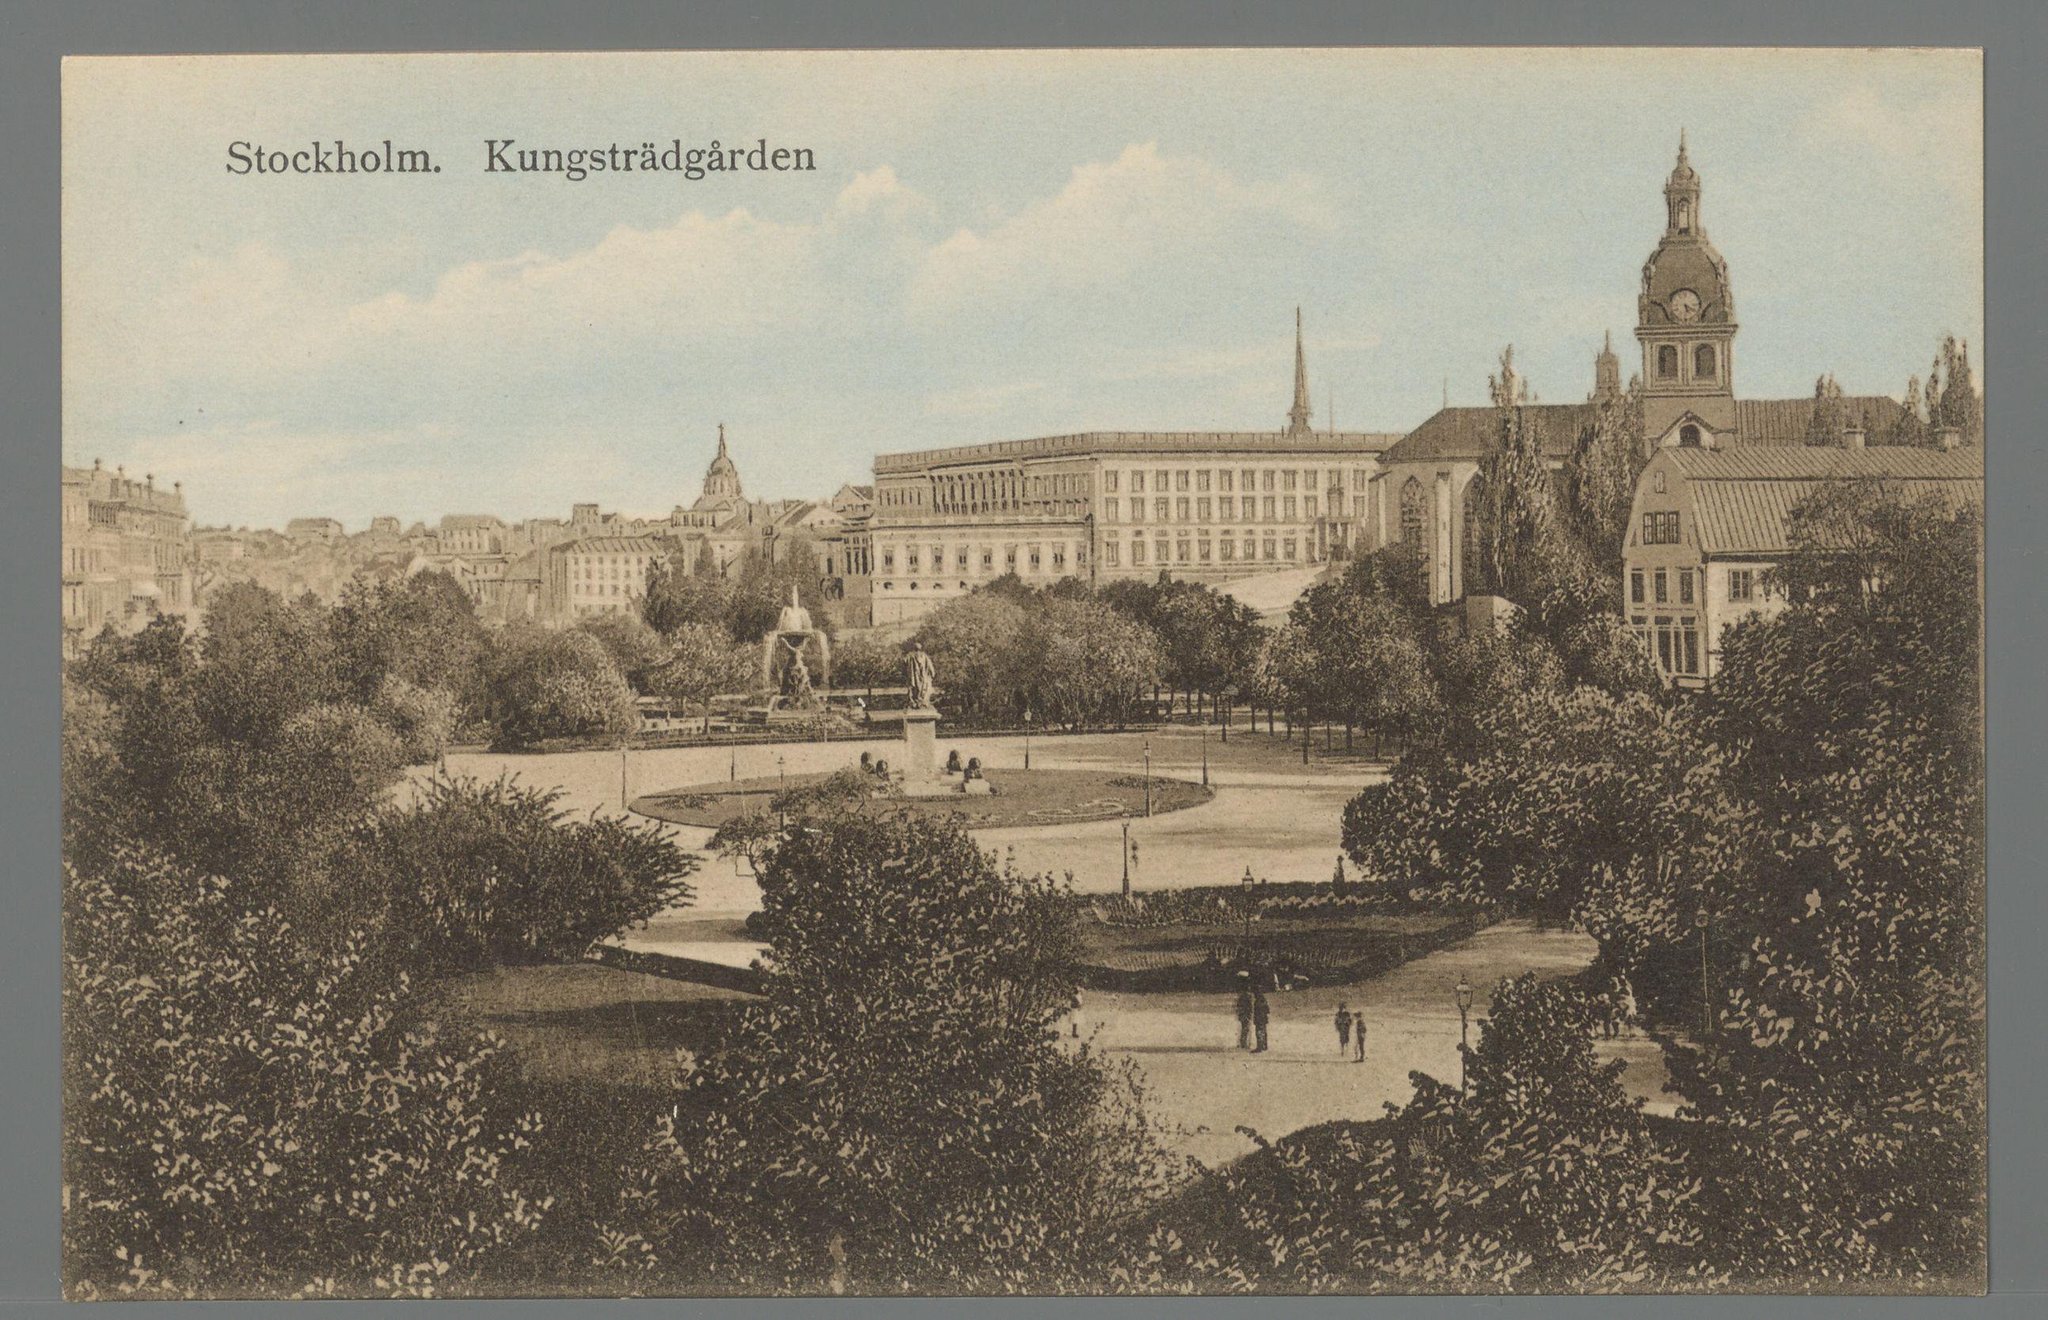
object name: photomechanical print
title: Stockholm. Kungsträdgården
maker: Anonymous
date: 1905-1930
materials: cardboard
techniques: photograph, lithograph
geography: stockholm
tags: park